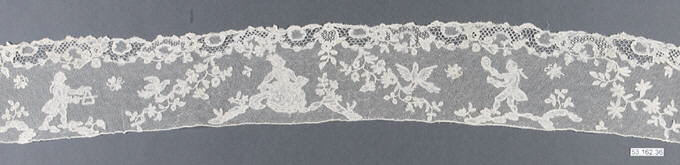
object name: border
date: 1701-1800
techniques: lace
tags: human figures,birds